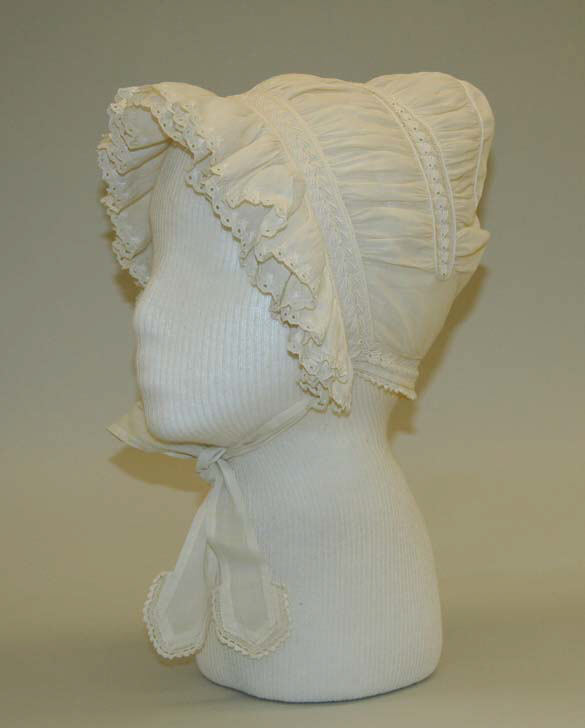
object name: cap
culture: american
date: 1812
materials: linen